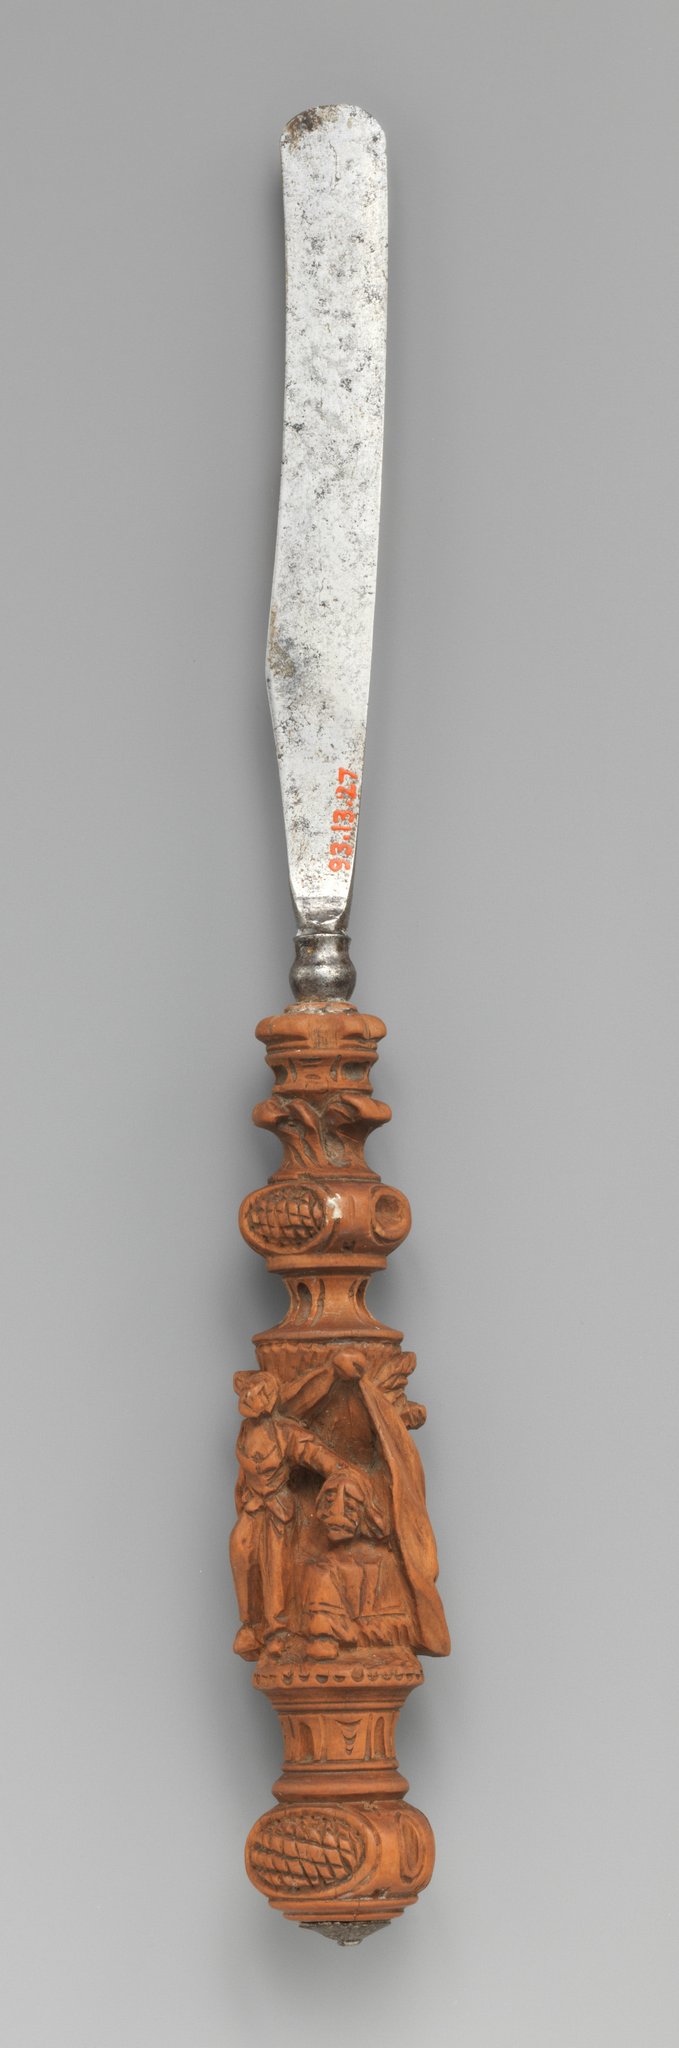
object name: fruit knife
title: Fruit knife with carved scene from the story of Judith and Holofernes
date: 1701-1733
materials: steel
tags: holofernes,judith